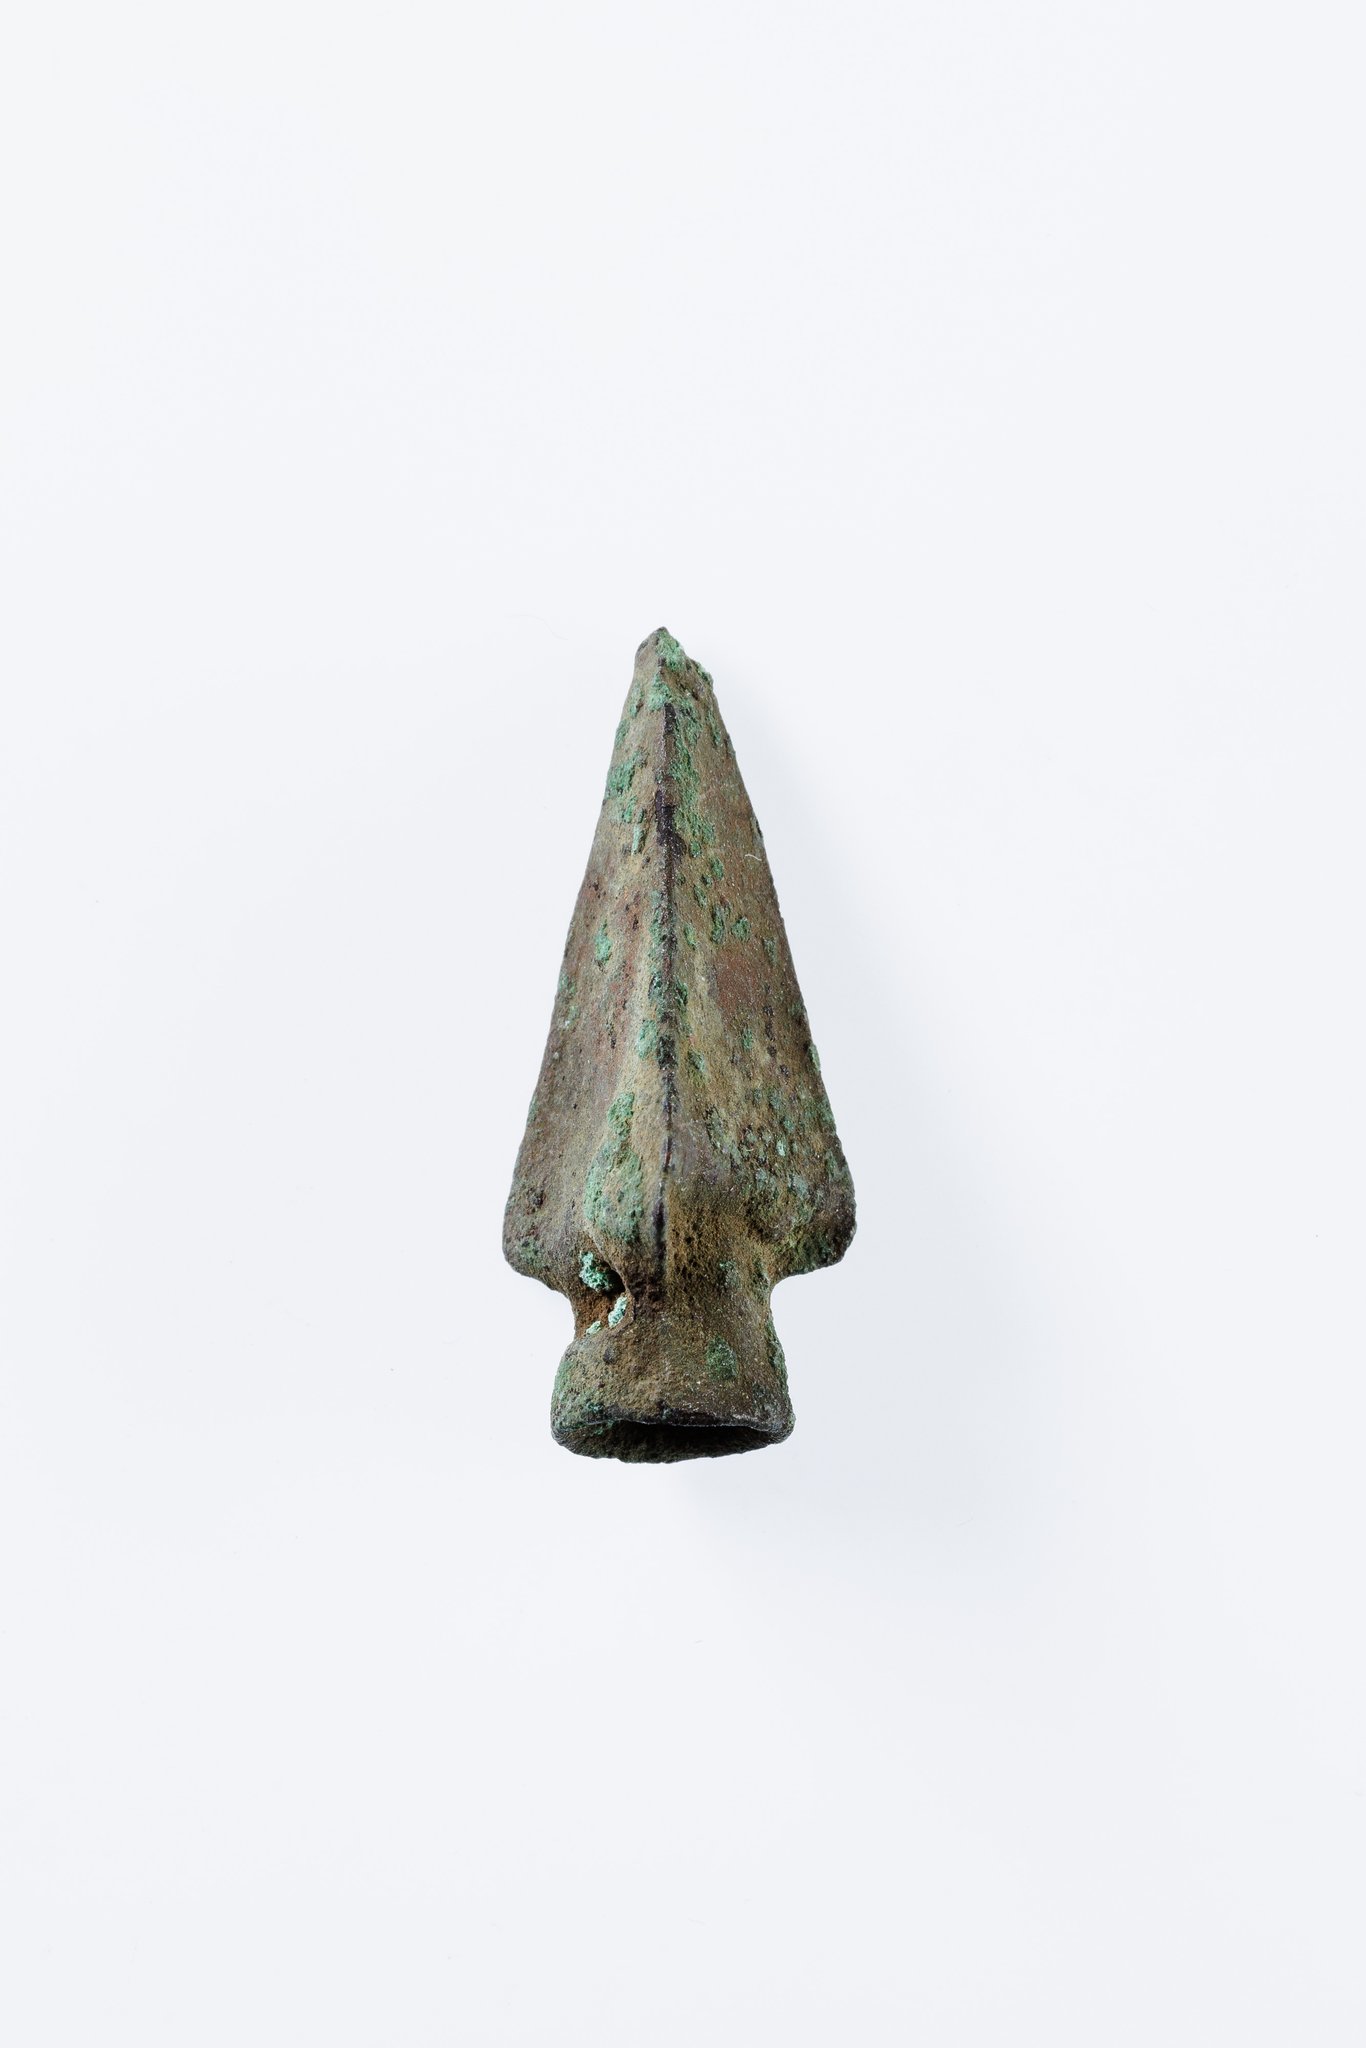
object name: arrow point, apries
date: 589-570 BCE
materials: bronze, copper alloy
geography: egypt